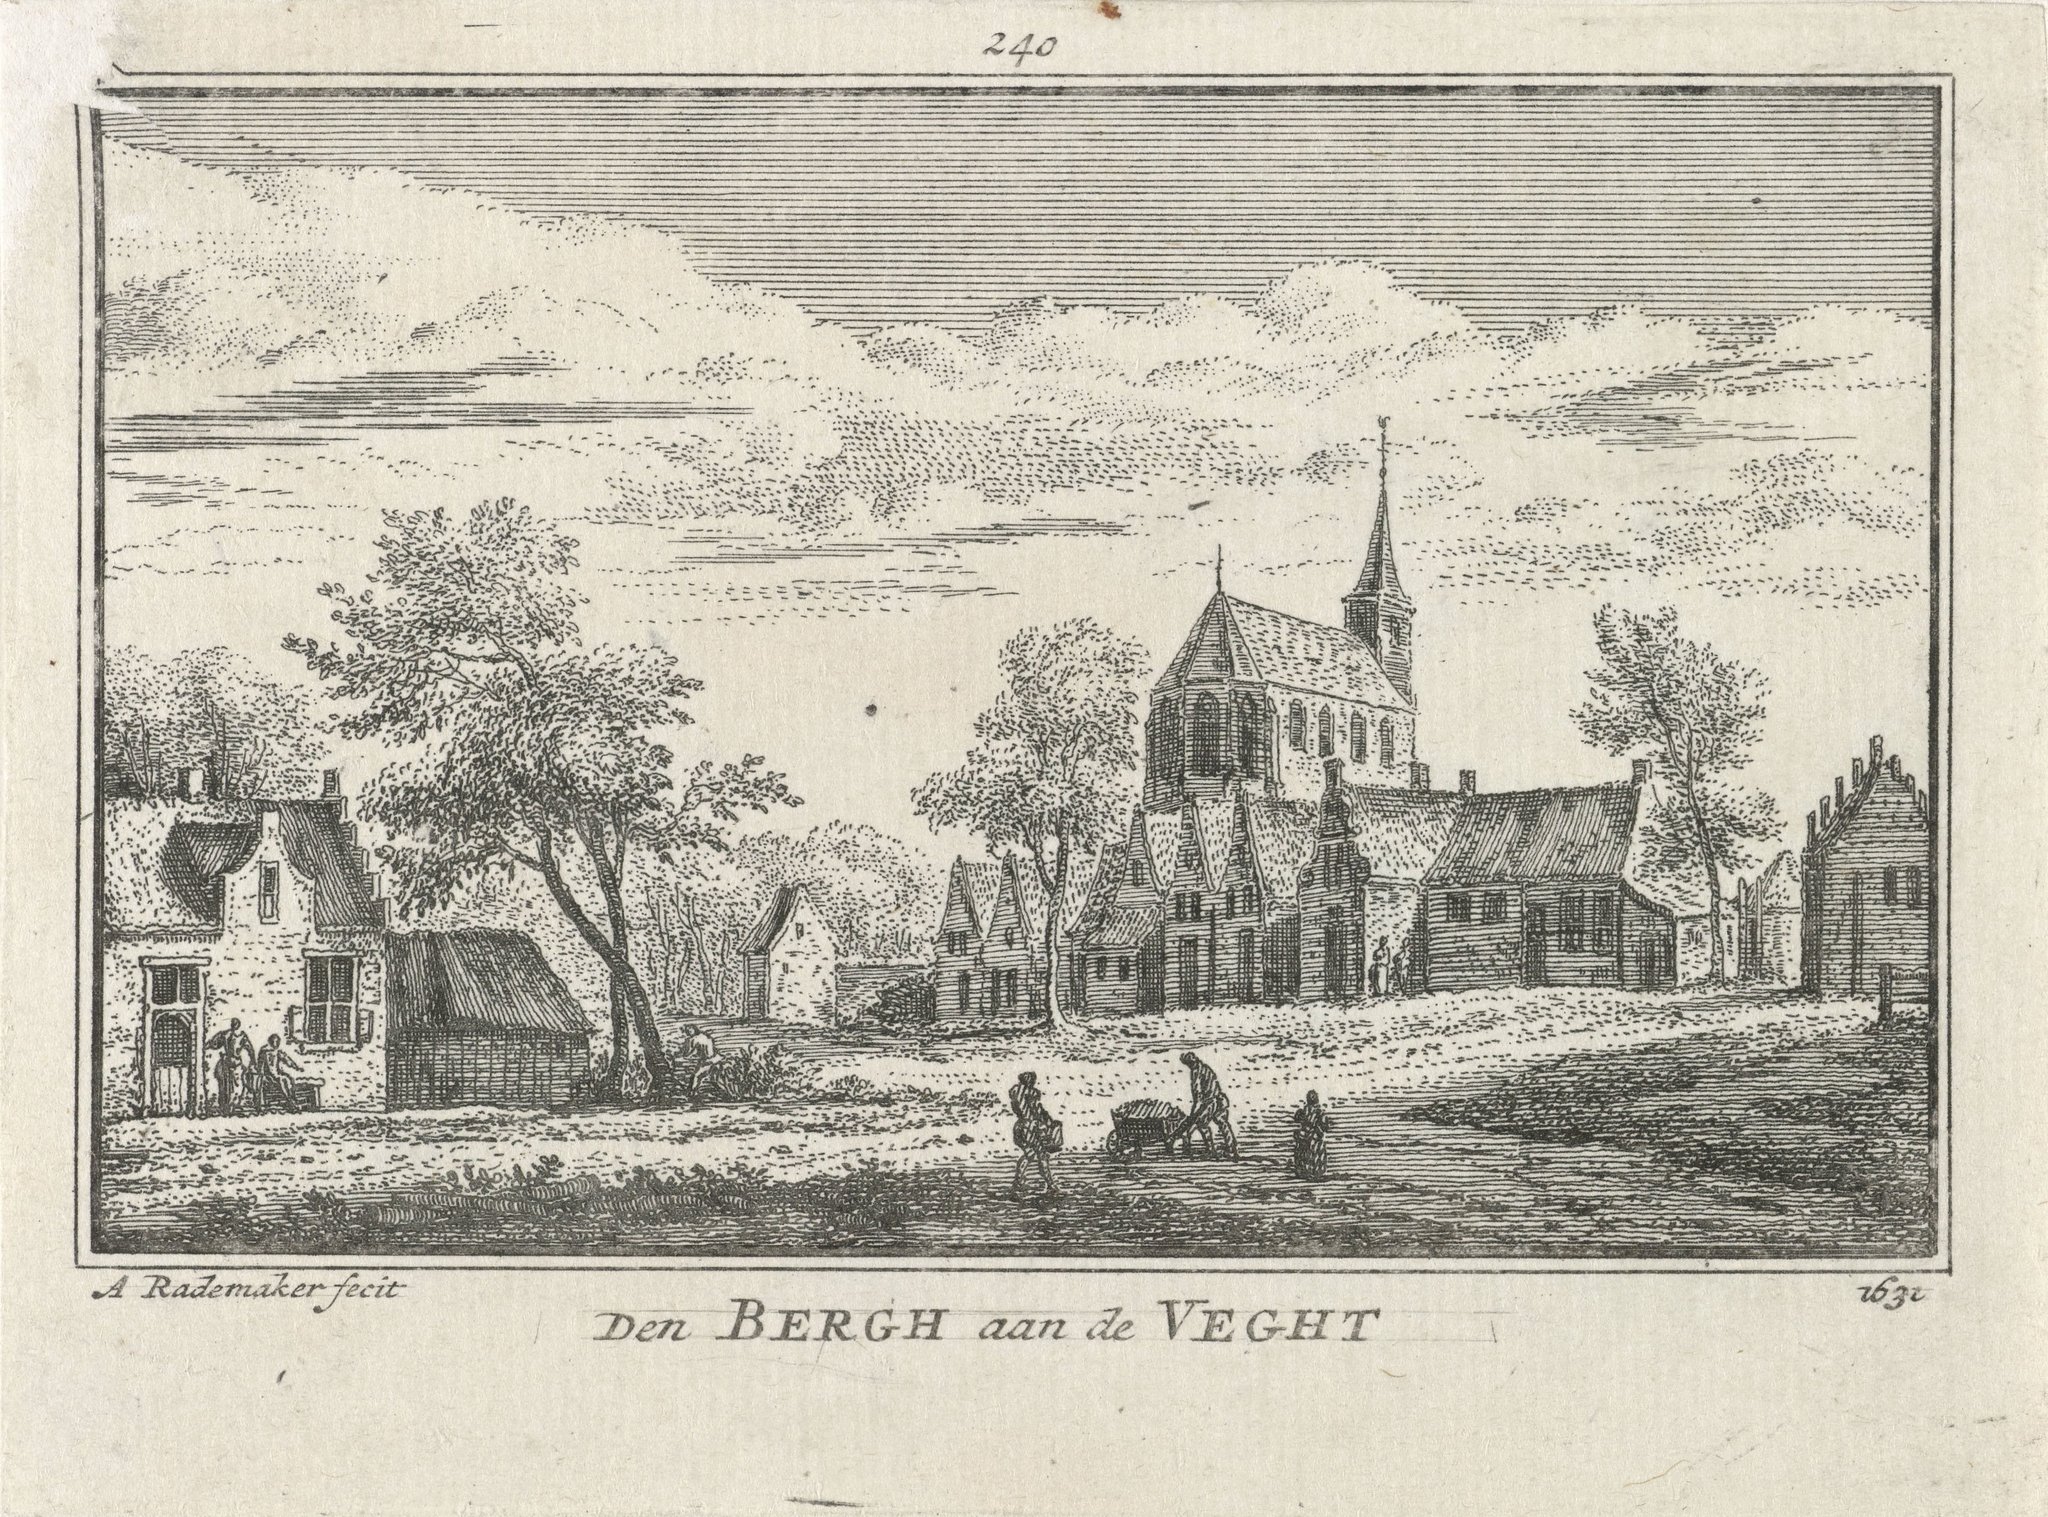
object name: book illustration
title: Gezicht op Nederhorst den Berg, 1631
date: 1727-1733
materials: paper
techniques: etching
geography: amsterdam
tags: church (exterior), nederhorst den berg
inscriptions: collector's mark: Lugt 2228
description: Illustratie uit: Abraham Rademaker, Matthaeus Brouërius van Niedek, Isaac Le Long, Kabinet van Nederlandsche en Kleefsche outheden en (...) voorname stads- en landgebouwen, Willem Barents en Antoni Schoonenburg: Amsterdam, 1727-1733, ill. nr. 240.